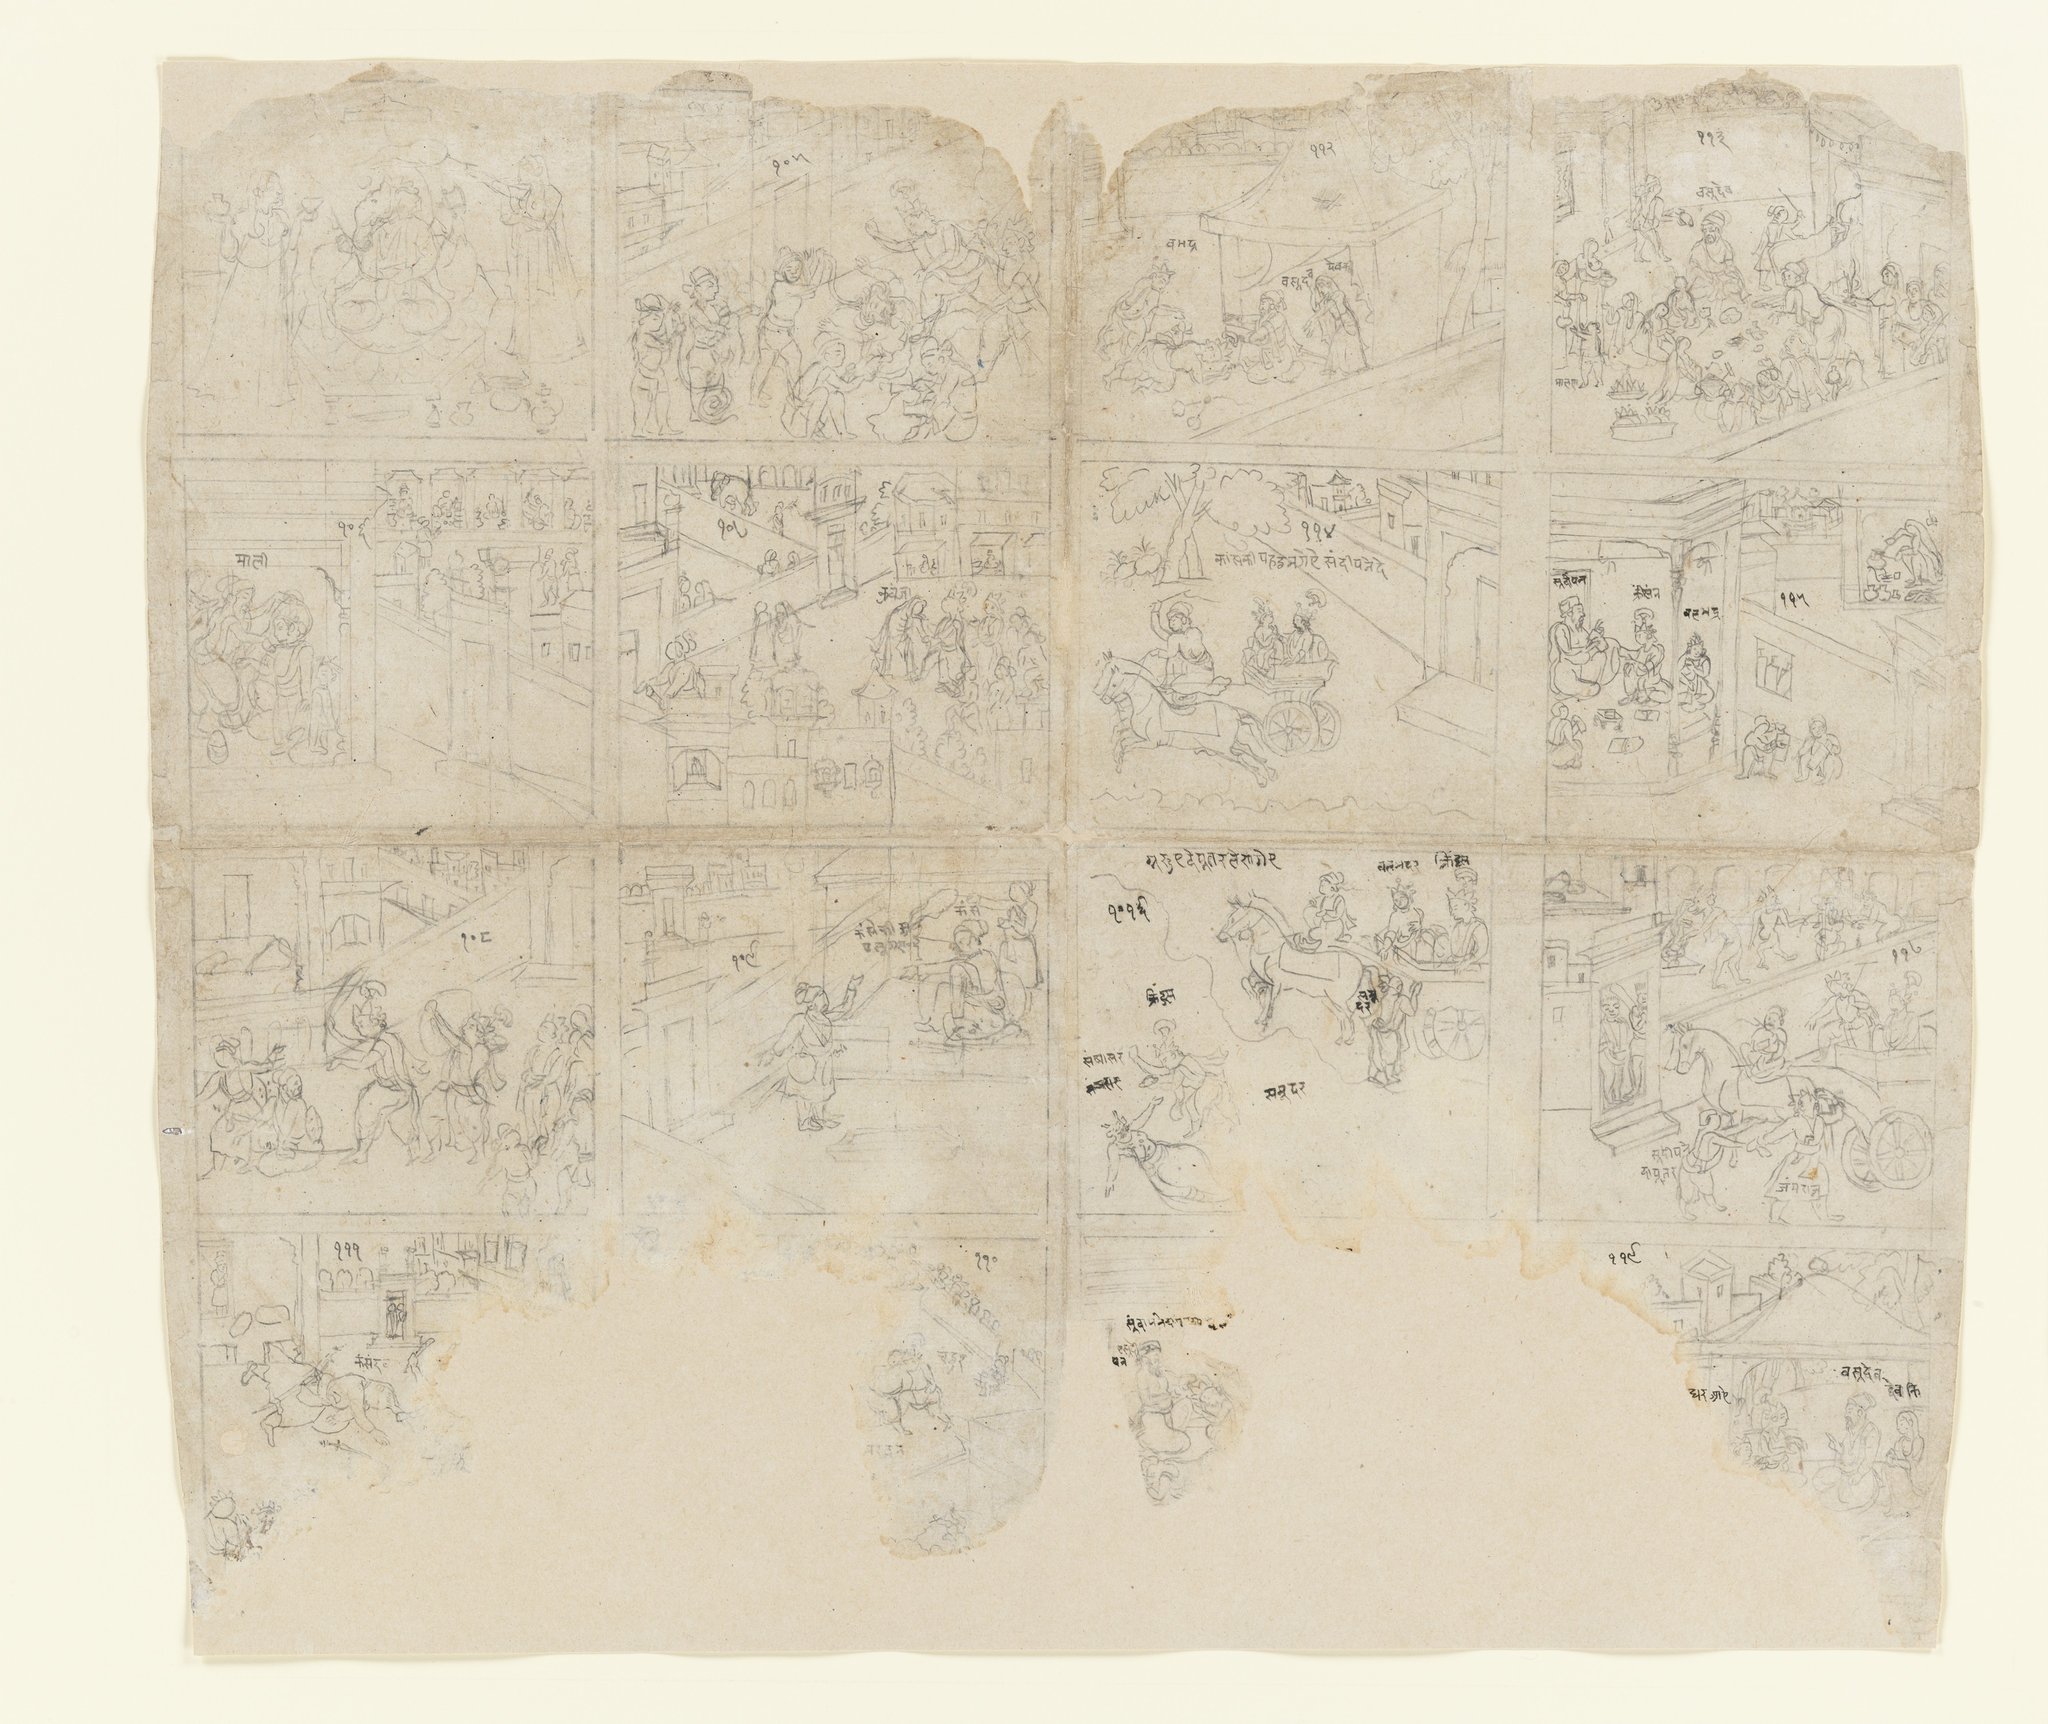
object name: painting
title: Scenes from the Bhagavata Purana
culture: india, pahari hills, kangra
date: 1801-1833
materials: ink, paper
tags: men,women,ganesha,krishna,hinduism,chariots